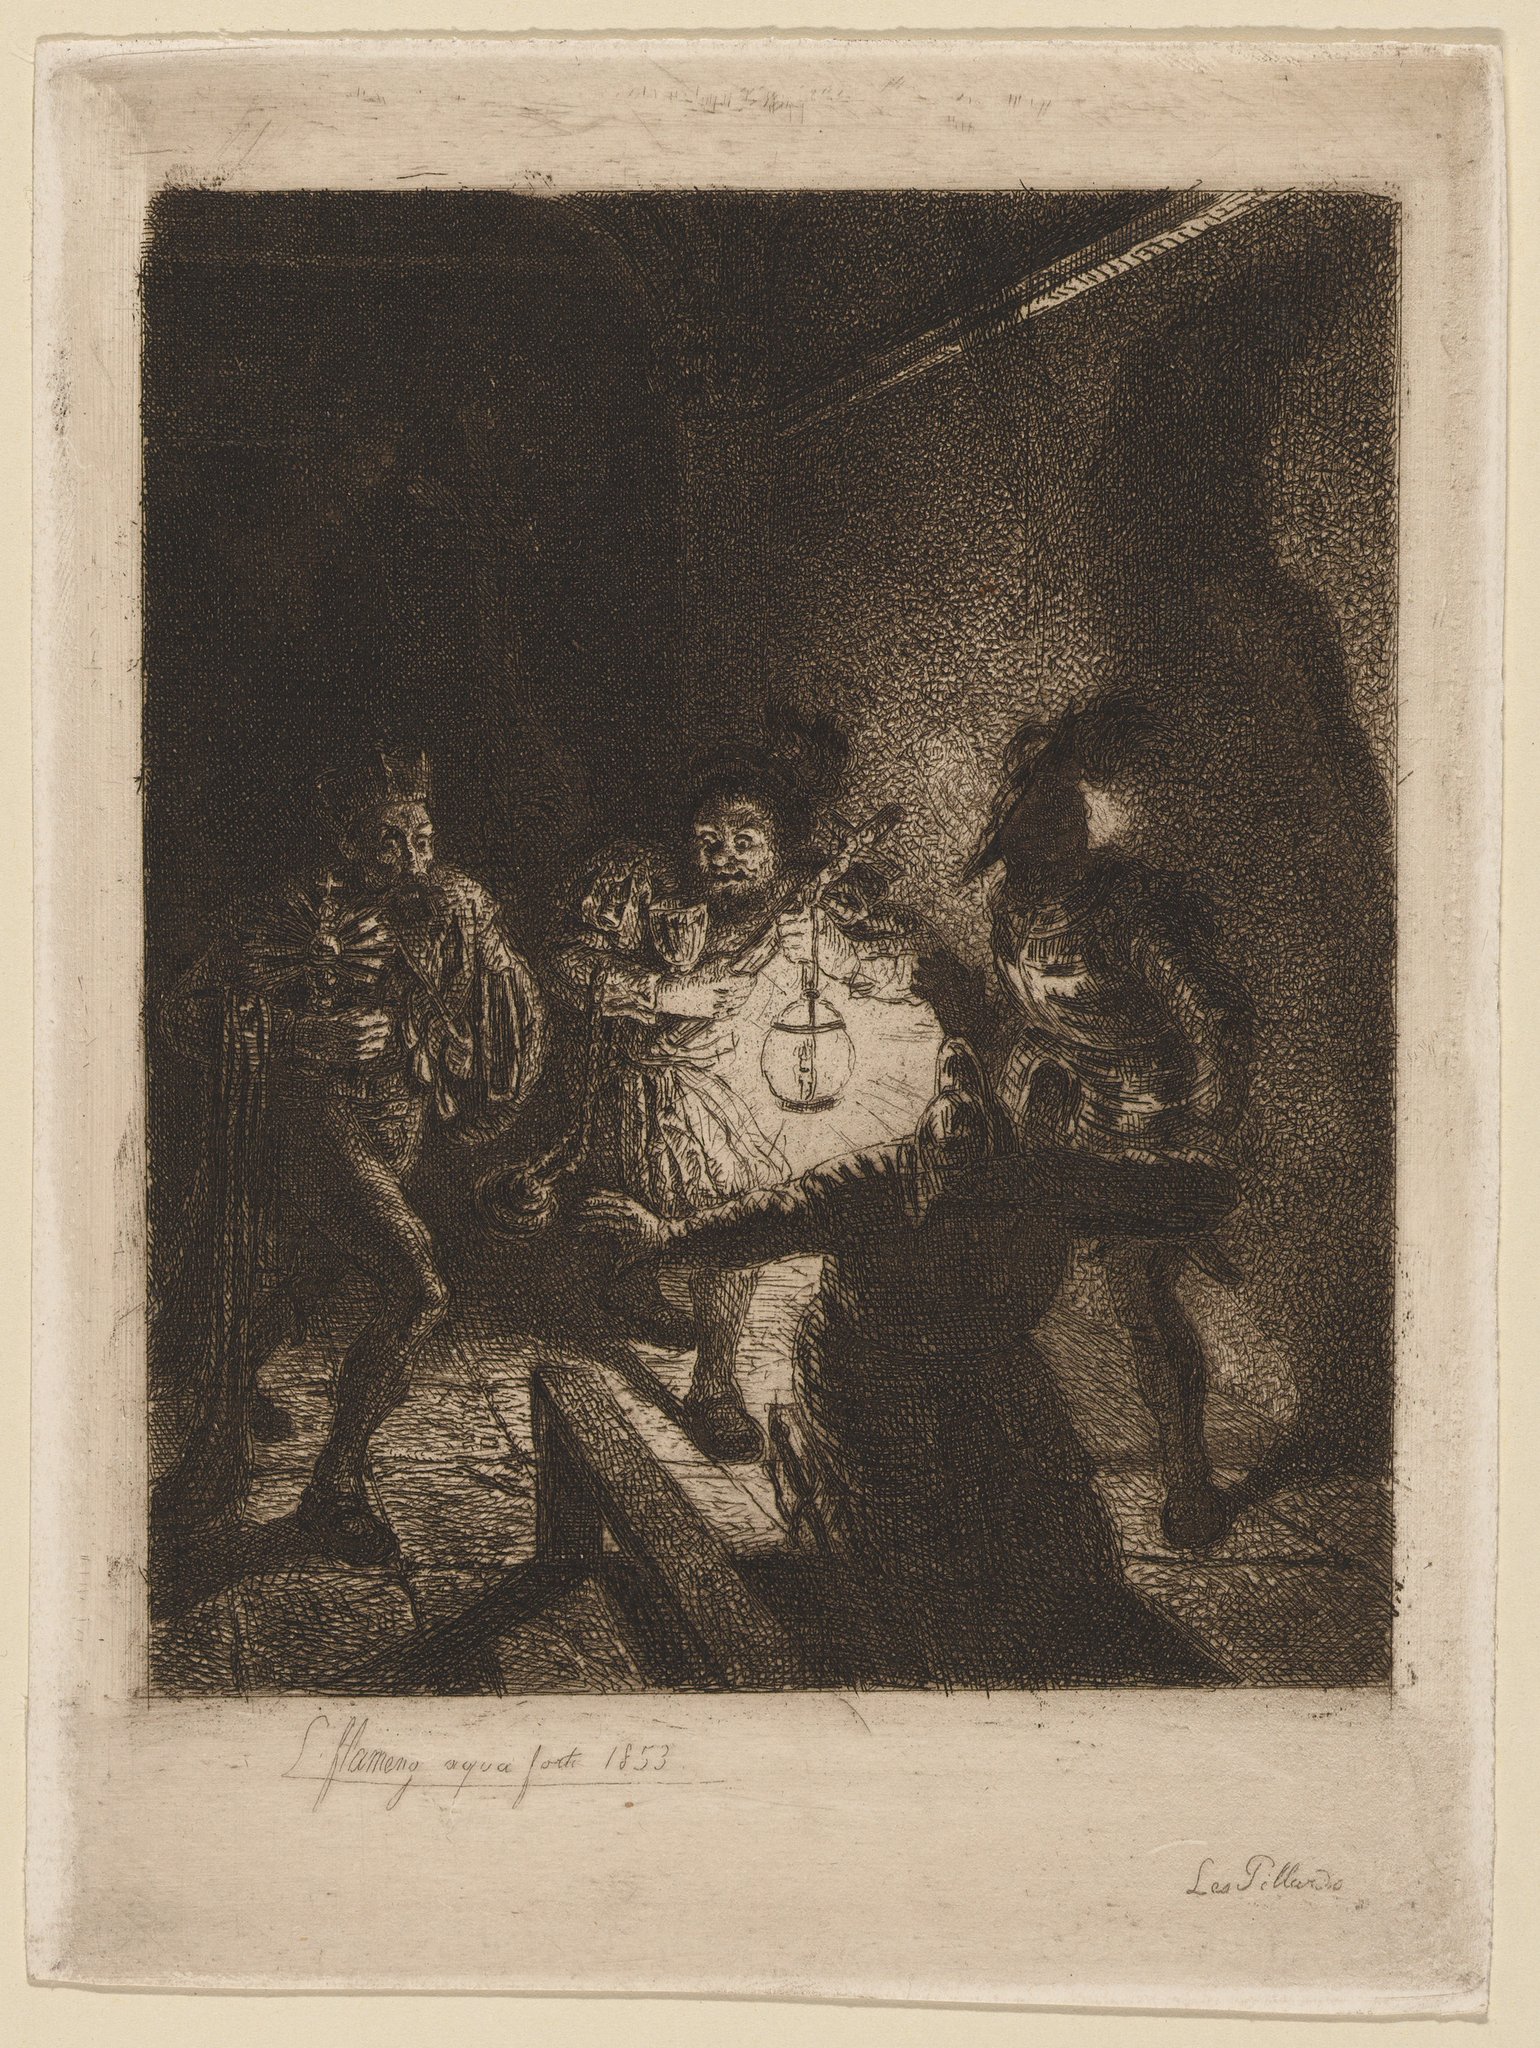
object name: print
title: Les Pillards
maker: léopold flameng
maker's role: engraver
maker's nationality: french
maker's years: 1831-1911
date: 1853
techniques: etching